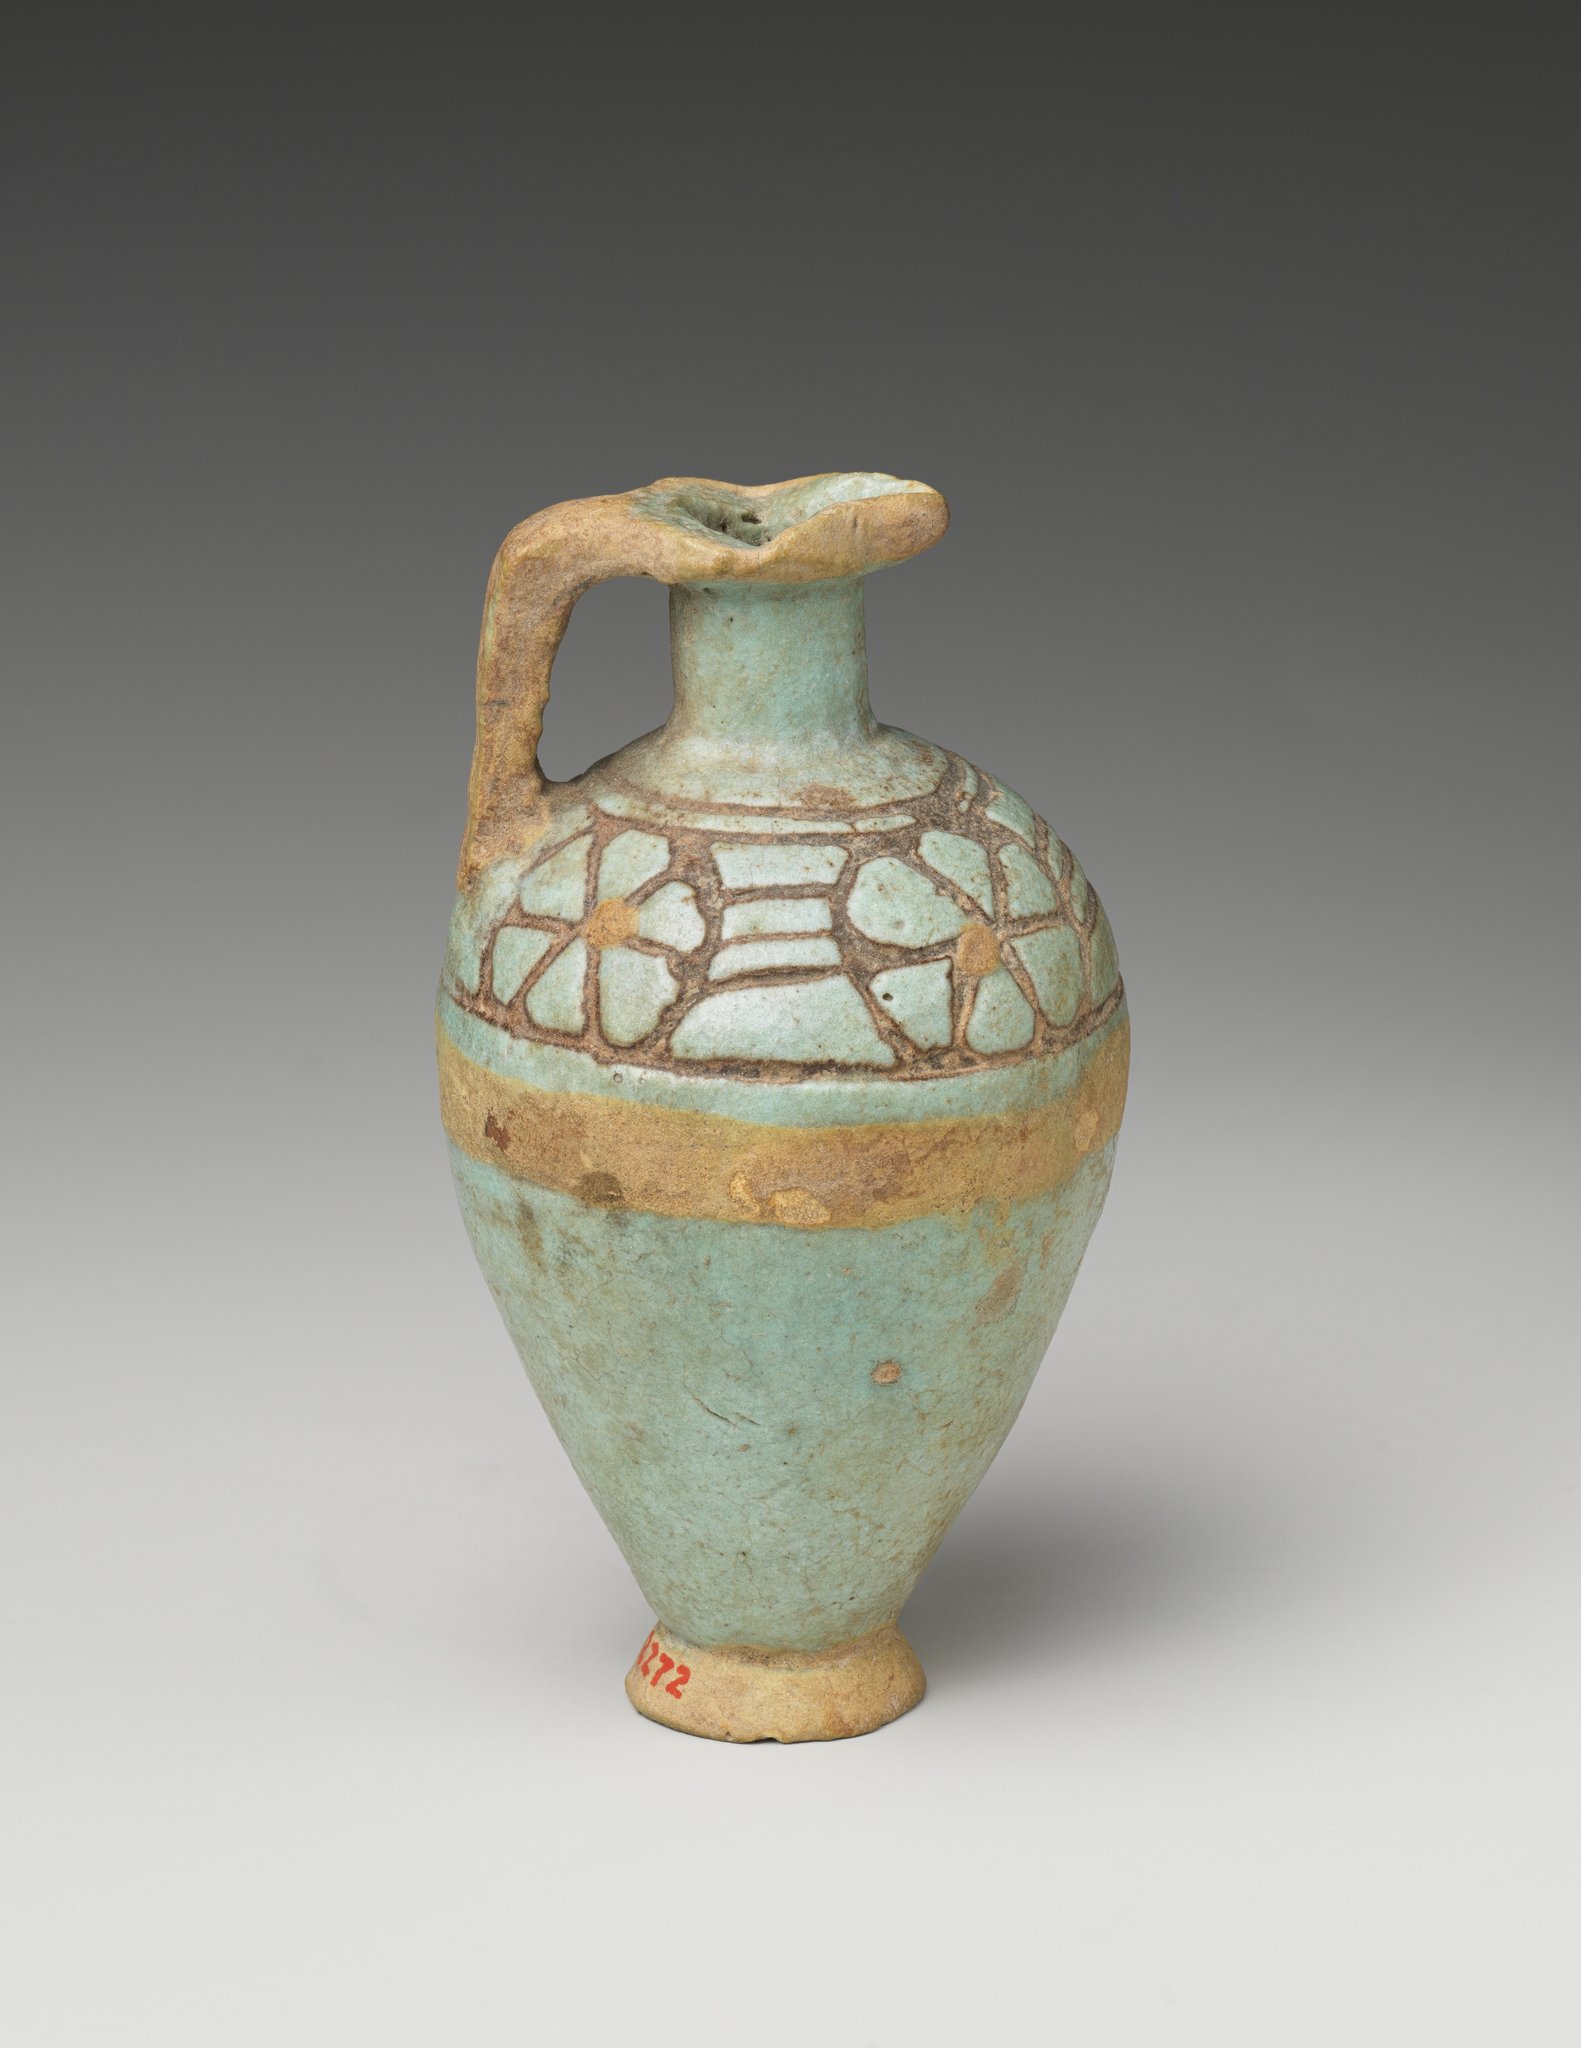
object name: jug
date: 664-332 BCE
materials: faience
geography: egypt